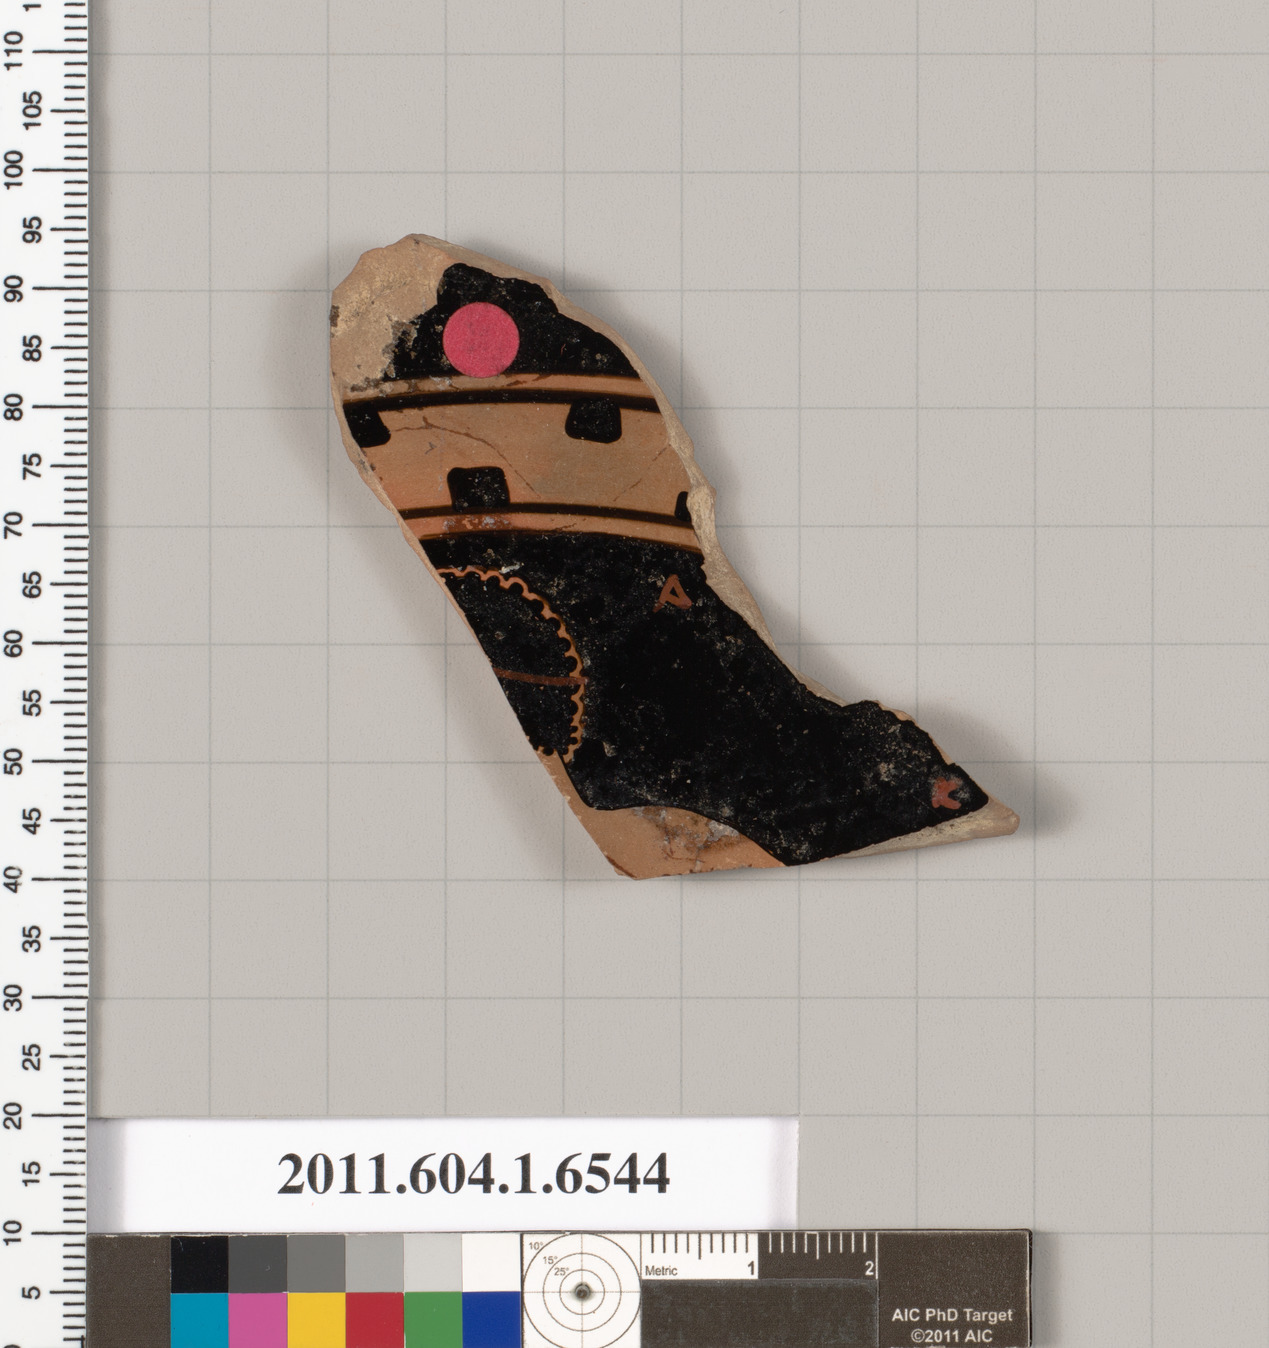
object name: kylix fragment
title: Terracotta fragment of a kylix (drinking cup)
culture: greek, attic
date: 490-480 BCE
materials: terracotta